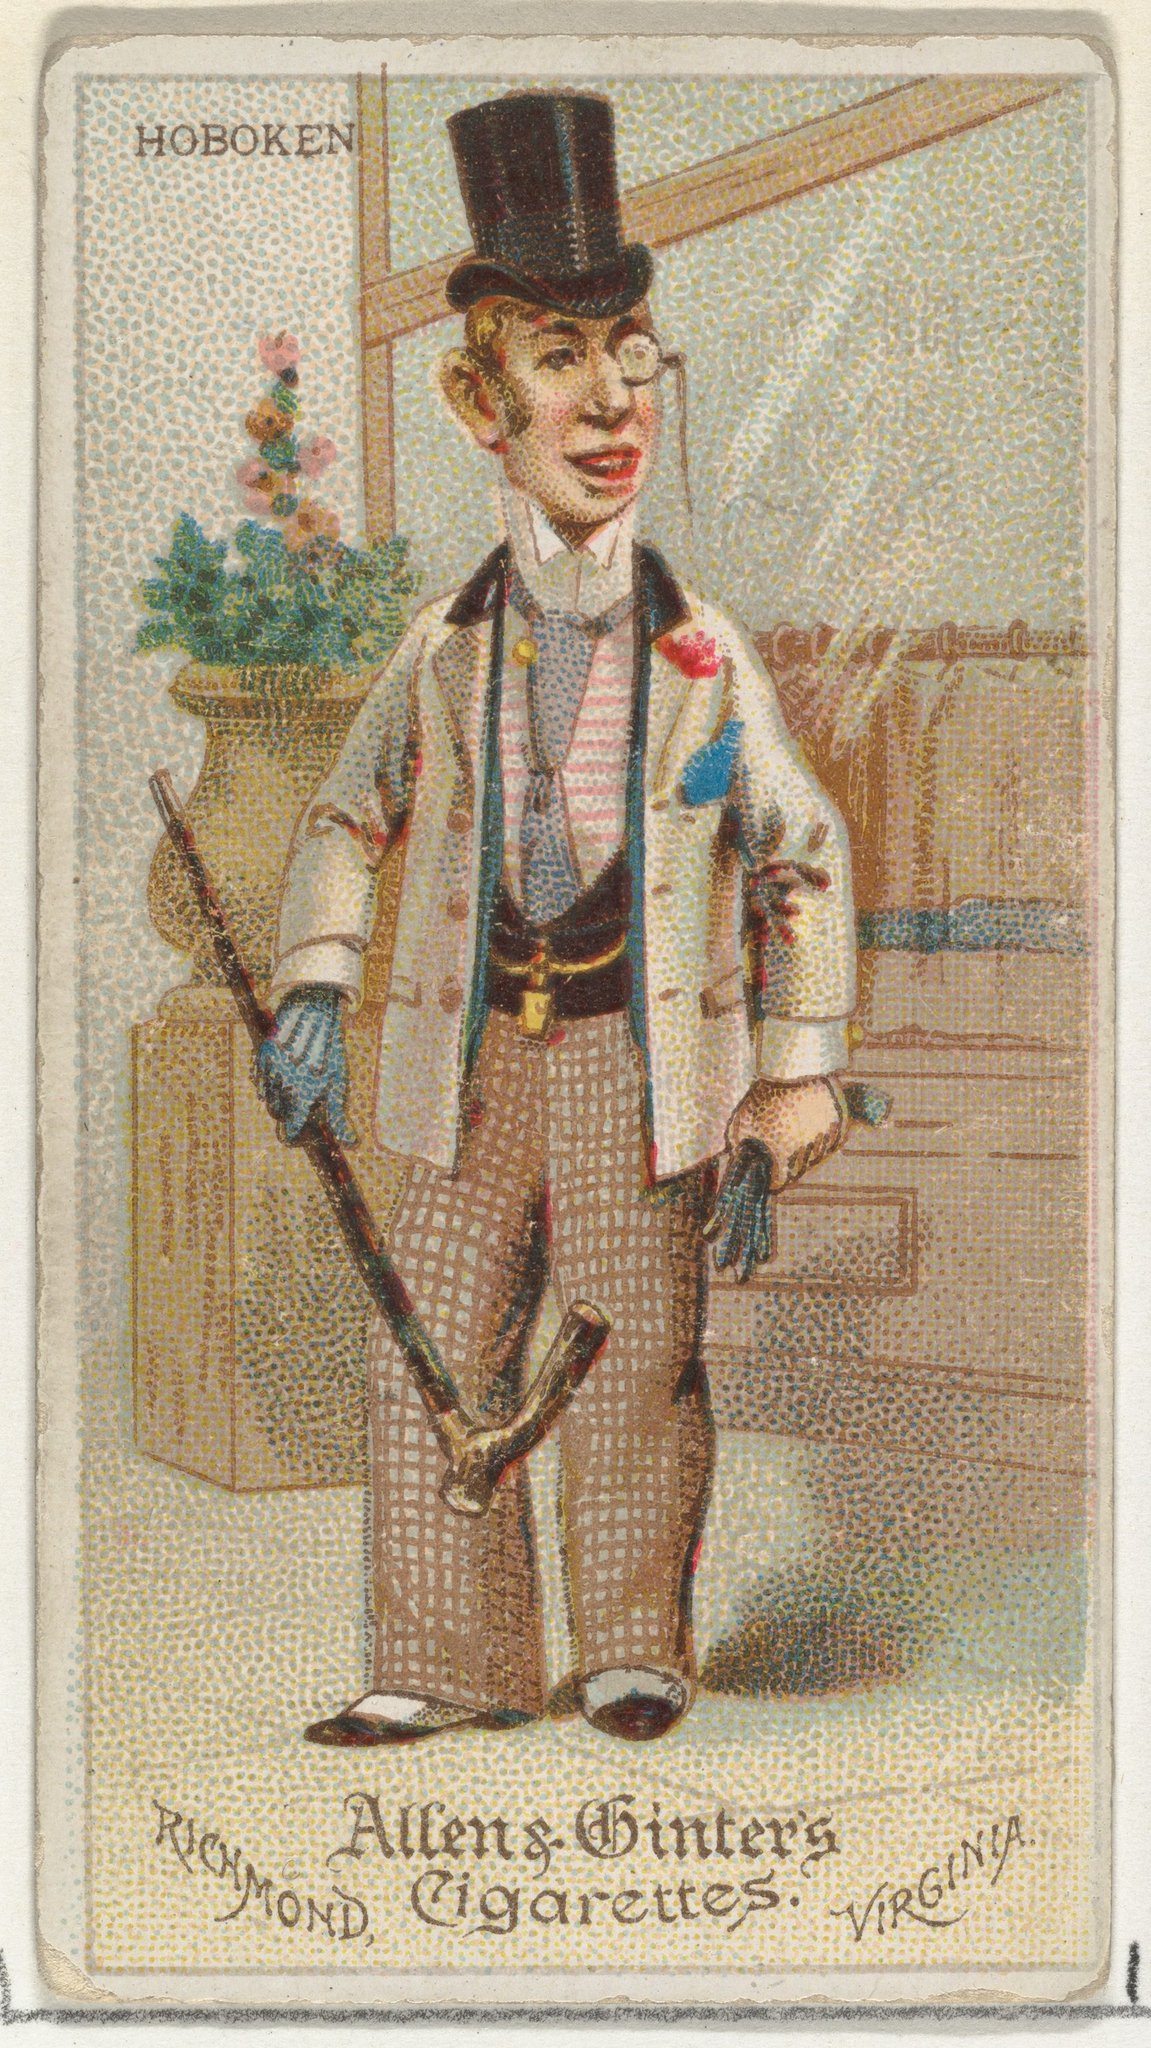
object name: print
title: Hoboken, from World's Dudes series (N31) for Allen & Ginter Cigarettes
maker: allen & ginter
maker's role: publisher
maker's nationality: american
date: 1888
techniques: color lithograph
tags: men